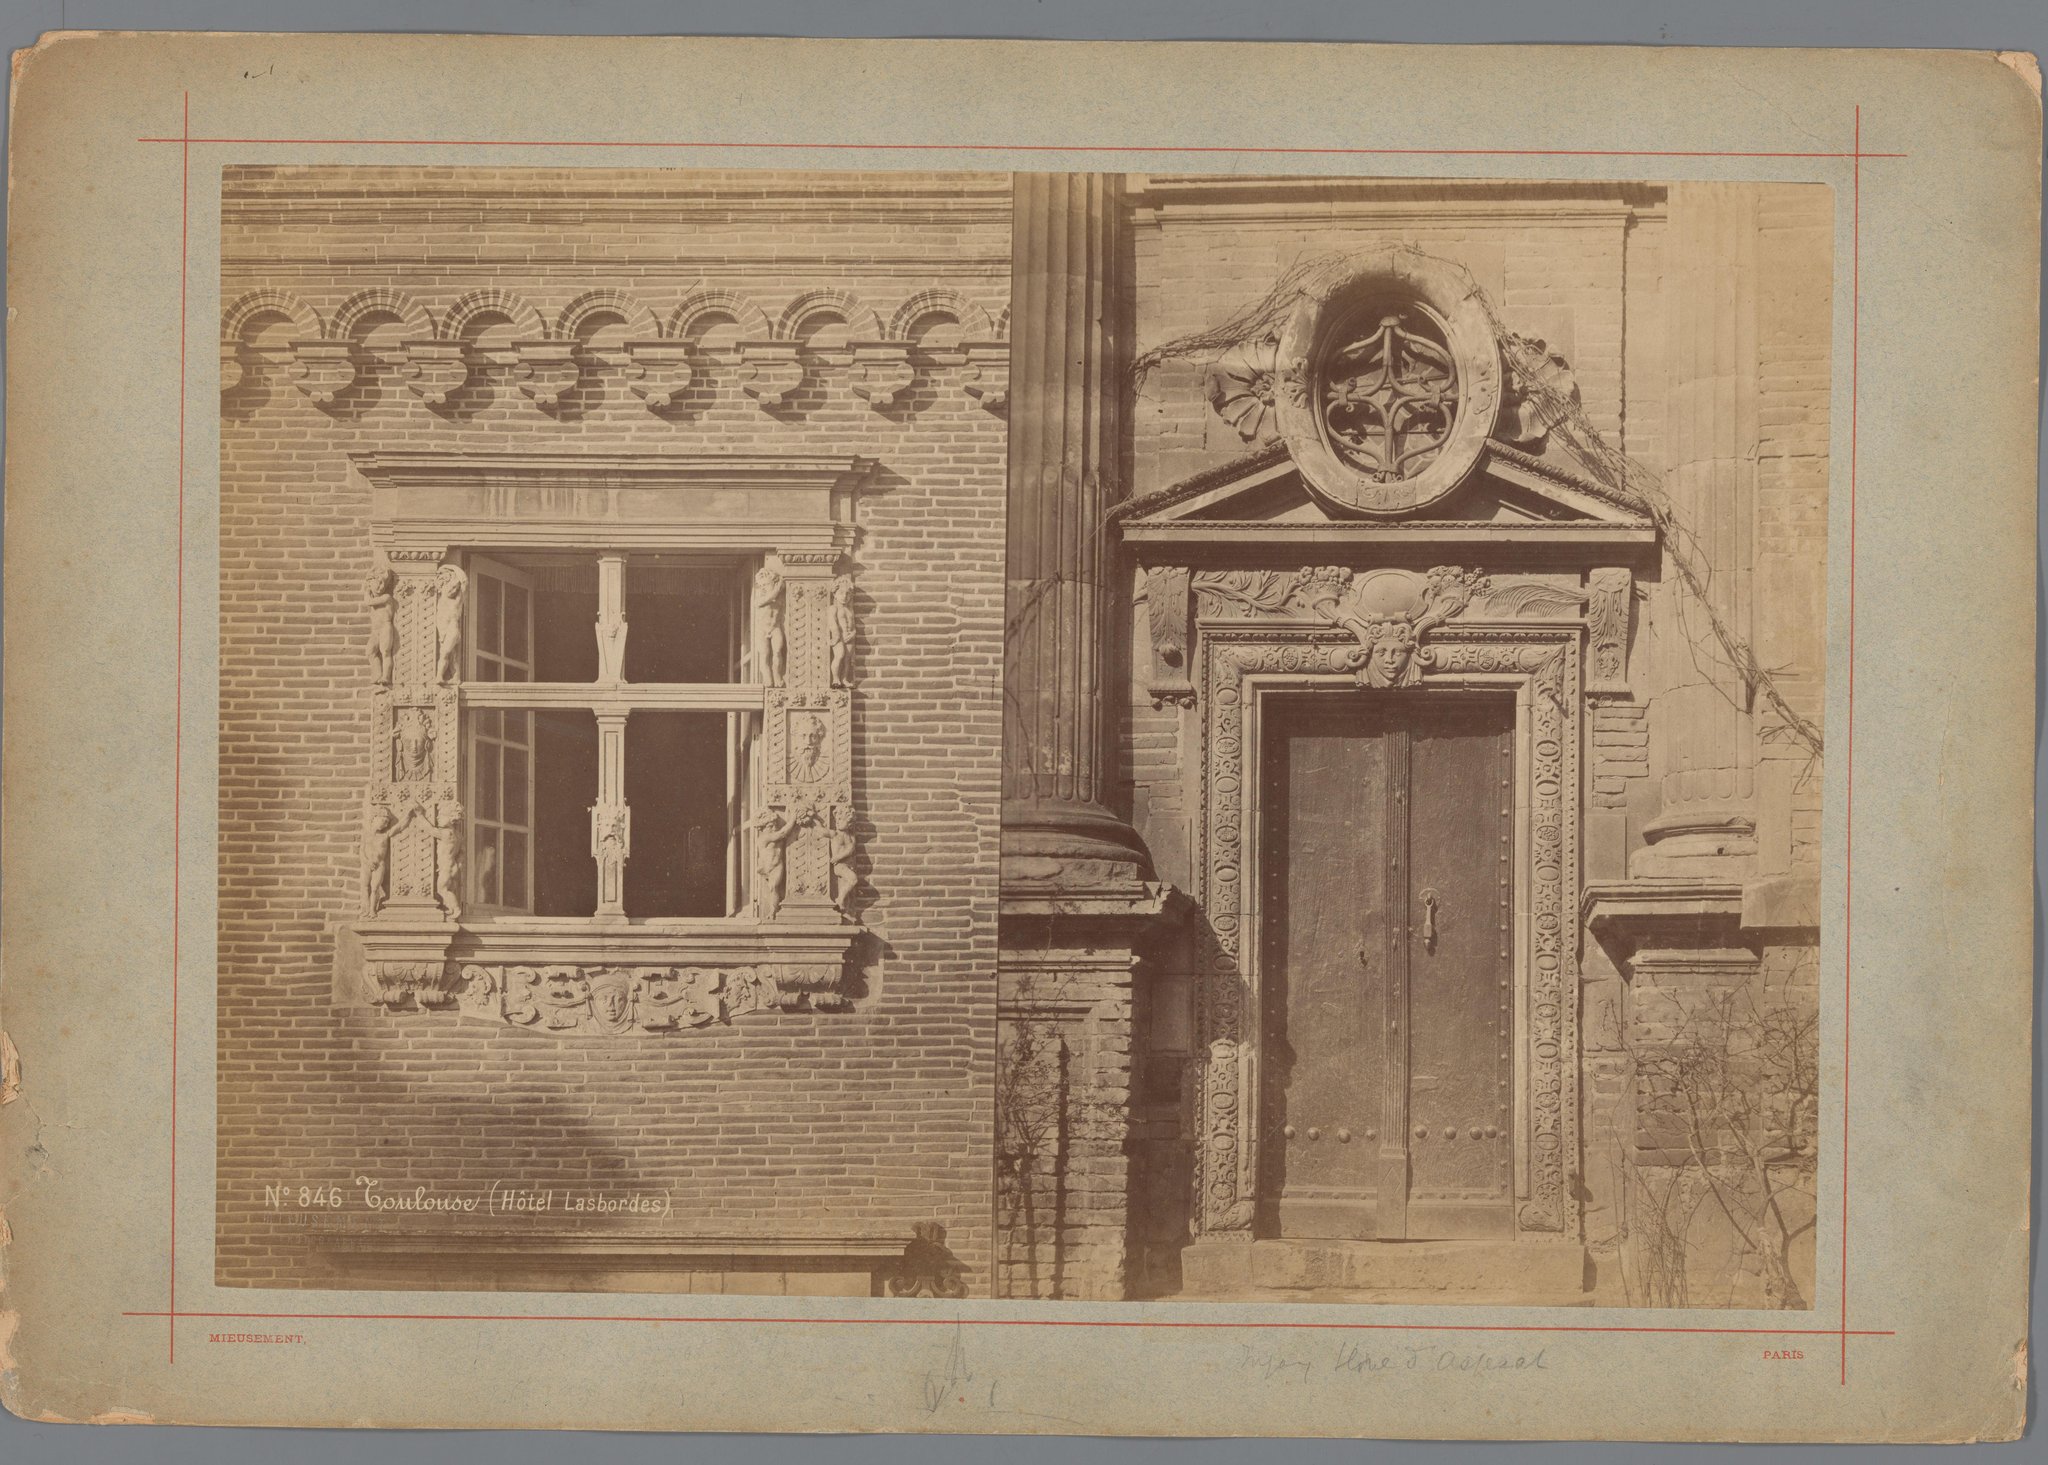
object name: photograph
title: Twee details van Hôtel de Lasbordes te Toulouse, links een venster gedecoreerd met mensfiguren en rechts een deur gedecoreerd met plantmotieven en een vrouwenhoofd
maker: séraphin-médéric mieusement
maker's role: fotograaf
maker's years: 1840-1905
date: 1875-1900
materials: cardboard, photographic support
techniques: albumen print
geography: toulouse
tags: window, ornament ~ human monstrosities, door, ornament derived from plant forms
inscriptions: name: ‘Monsters worden door de Representant J. A. G. de Leur den Haag op franco aanvrage verzonden’, collector's mark: Lugt 3937, number: ‘No. 846’